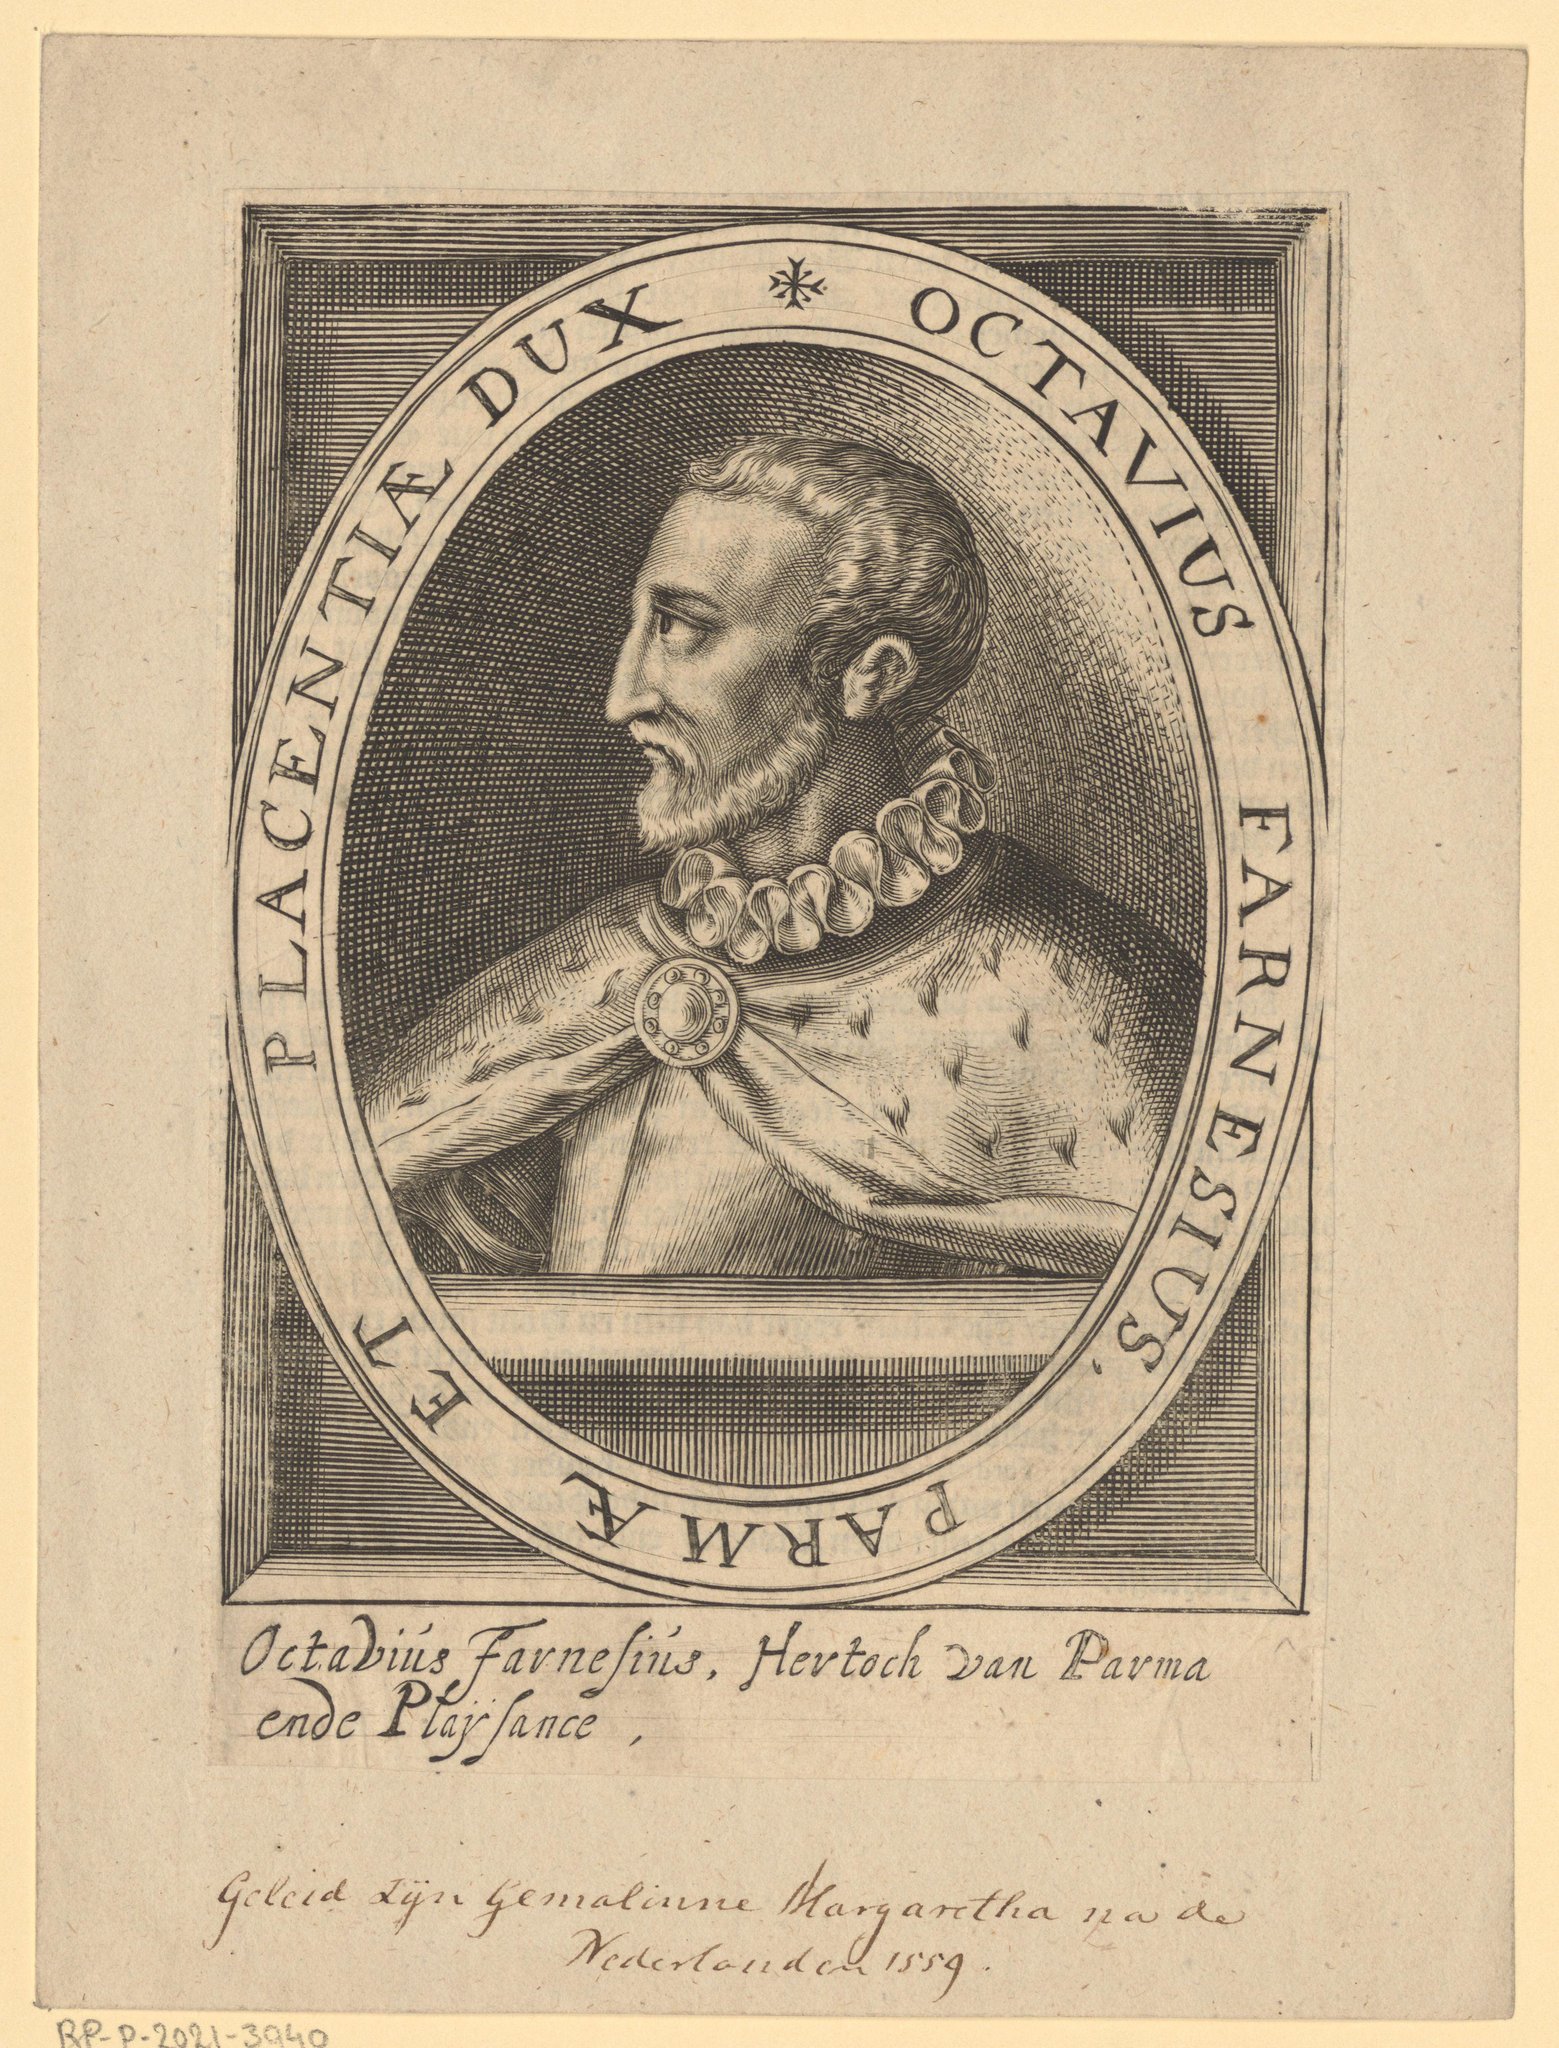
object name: book illustration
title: Portret van Ottavio Farnese, hertog van Parma en Piacenza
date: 1617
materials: paper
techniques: engraving, letterpress printing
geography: delft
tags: historical persons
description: Prent uit: Tooneel der beroemder hertogen, princen, graven ende krygs-helden. Delft: Nicolaes de Clerck, 1617, p. 470.